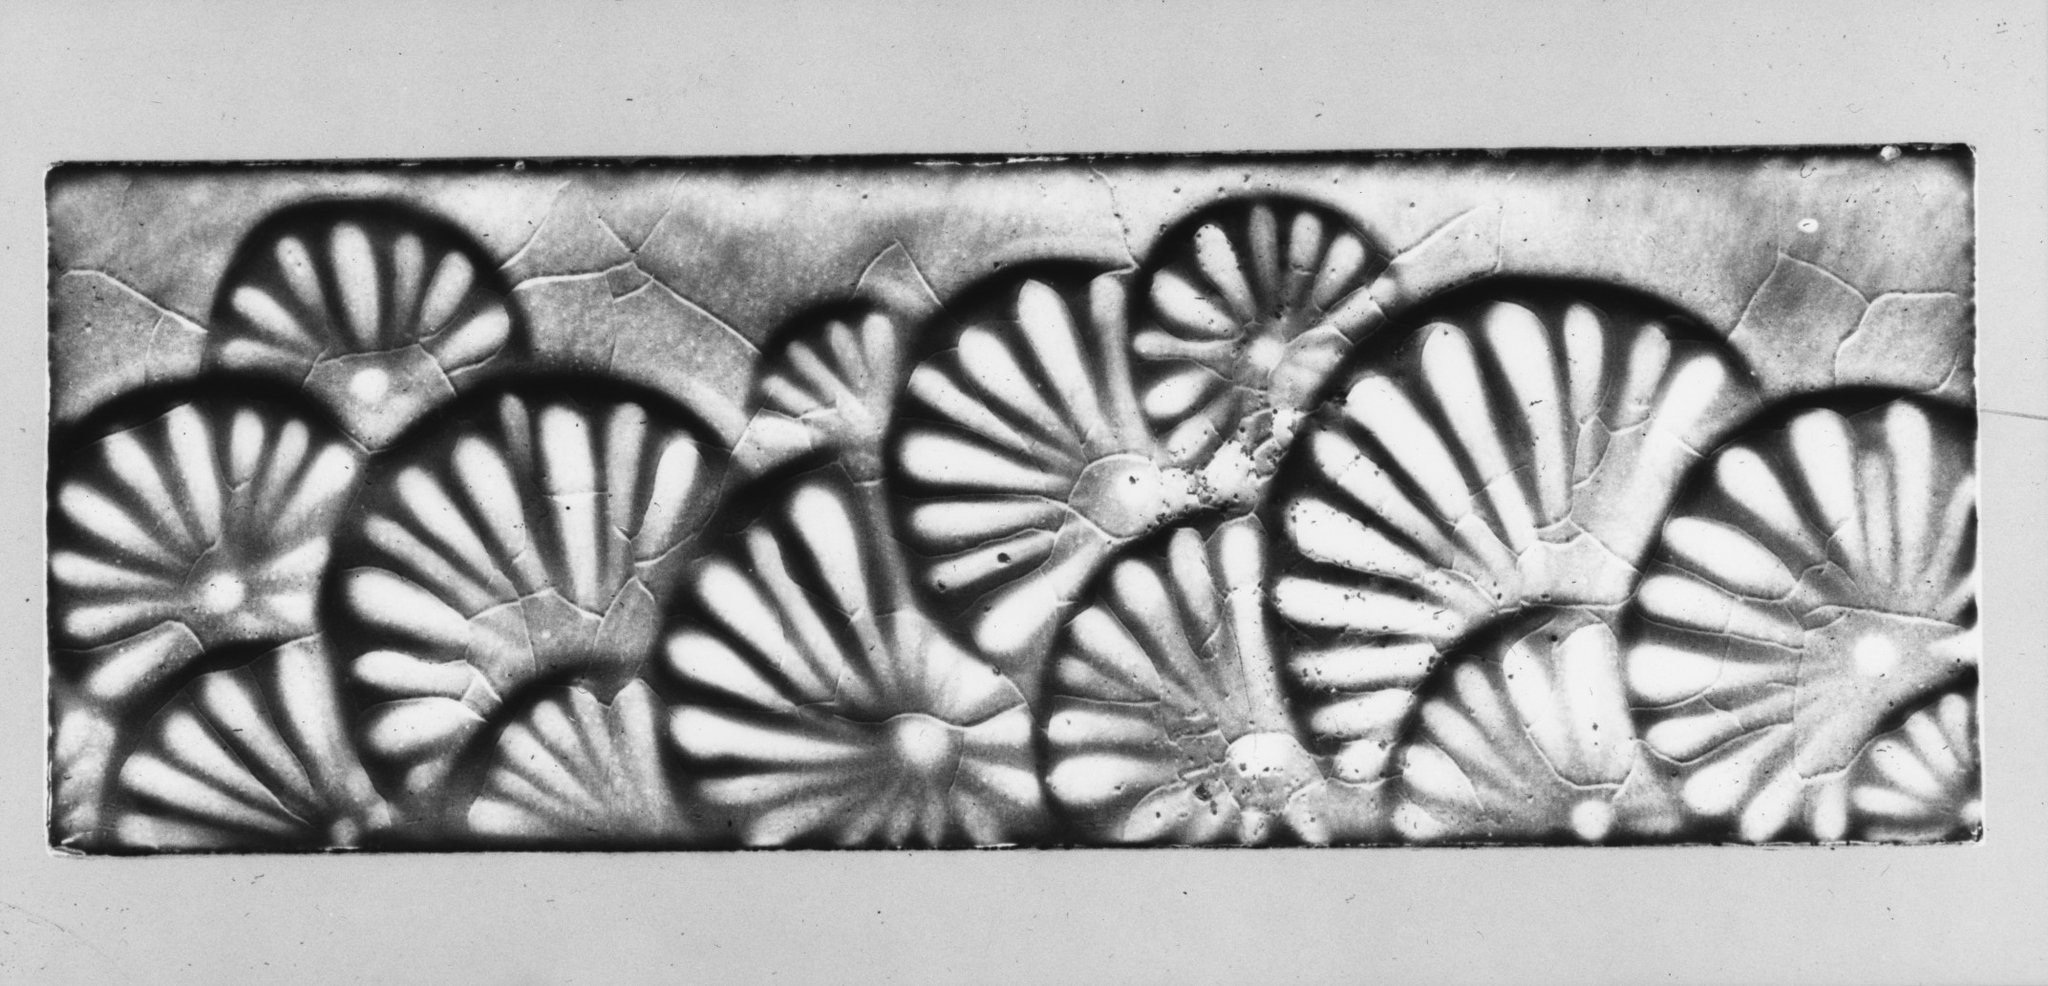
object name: tile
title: Border Tile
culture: american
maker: j. and j. g. low art tile works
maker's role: maker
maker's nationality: american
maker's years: 1877-1903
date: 1885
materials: earthenware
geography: united states